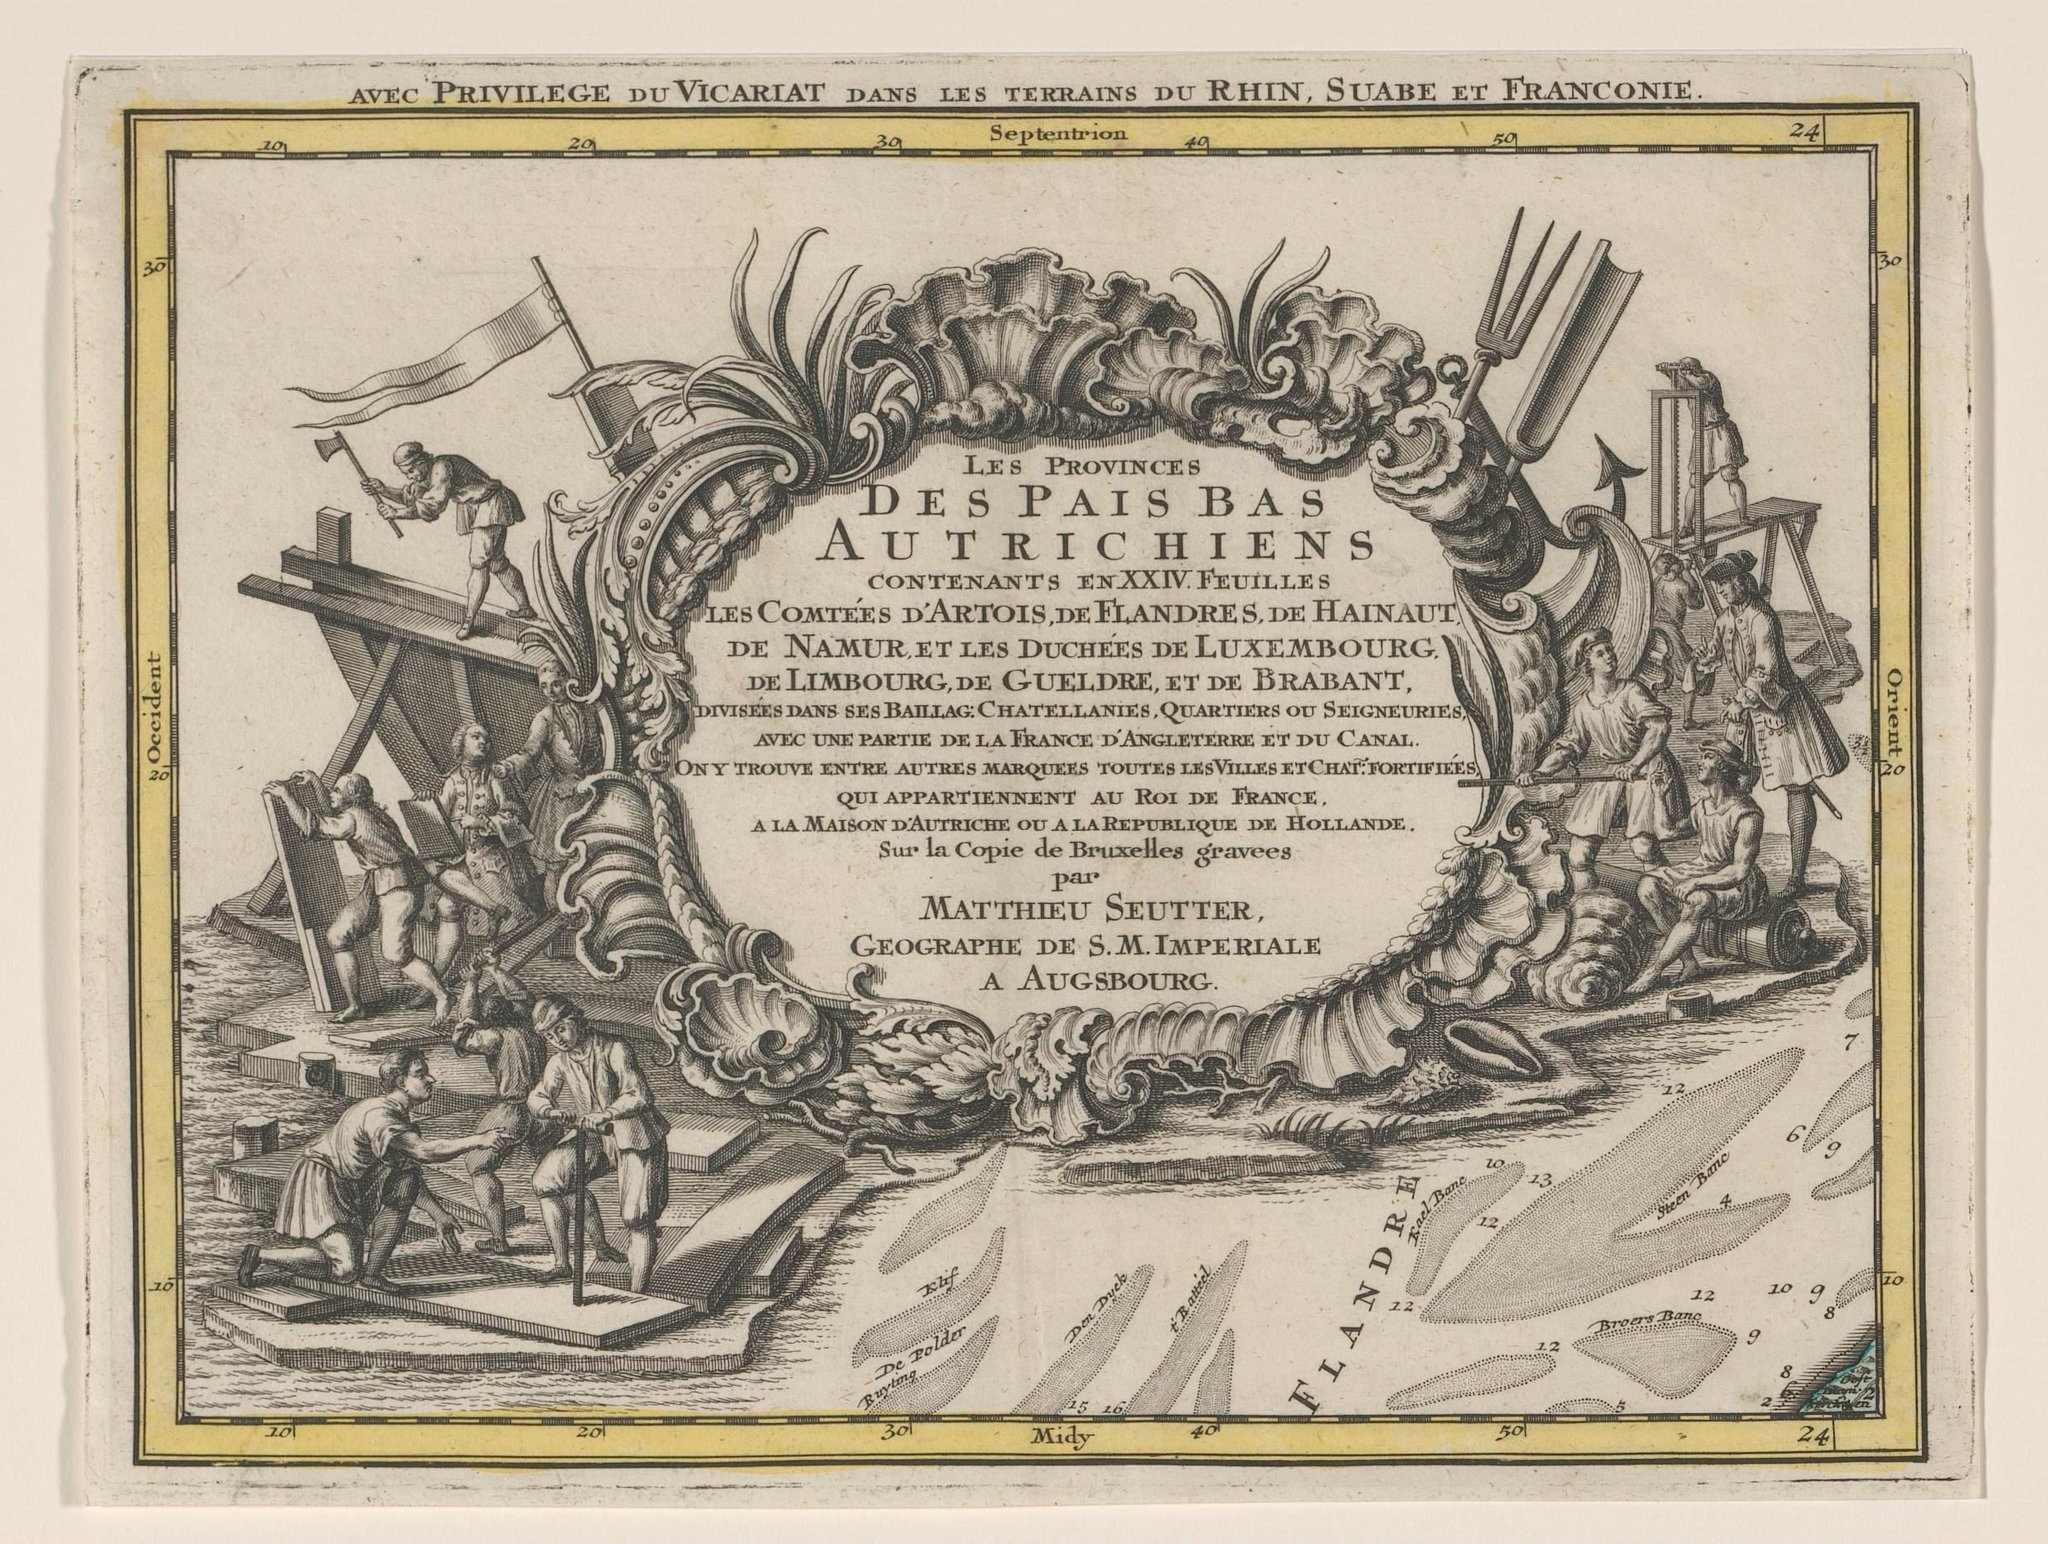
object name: print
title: Deel van een kaart van de Oostenrijkse Nederlanden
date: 1737-1757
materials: paper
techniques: engraving, etching, hand coloring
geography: augsburg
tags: maps of separate countries or regions, southern netherlands, belgium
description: Deze kaart is onderdeel van een wandkaart van de Oostenrijkse Nederlanden, bestaande uit vier rijen van zes delen. De delen van de kaart zijn rechtsonder genummerd, beginnend bij het deel linksboven (1) tot het deel rechtsonder (24).